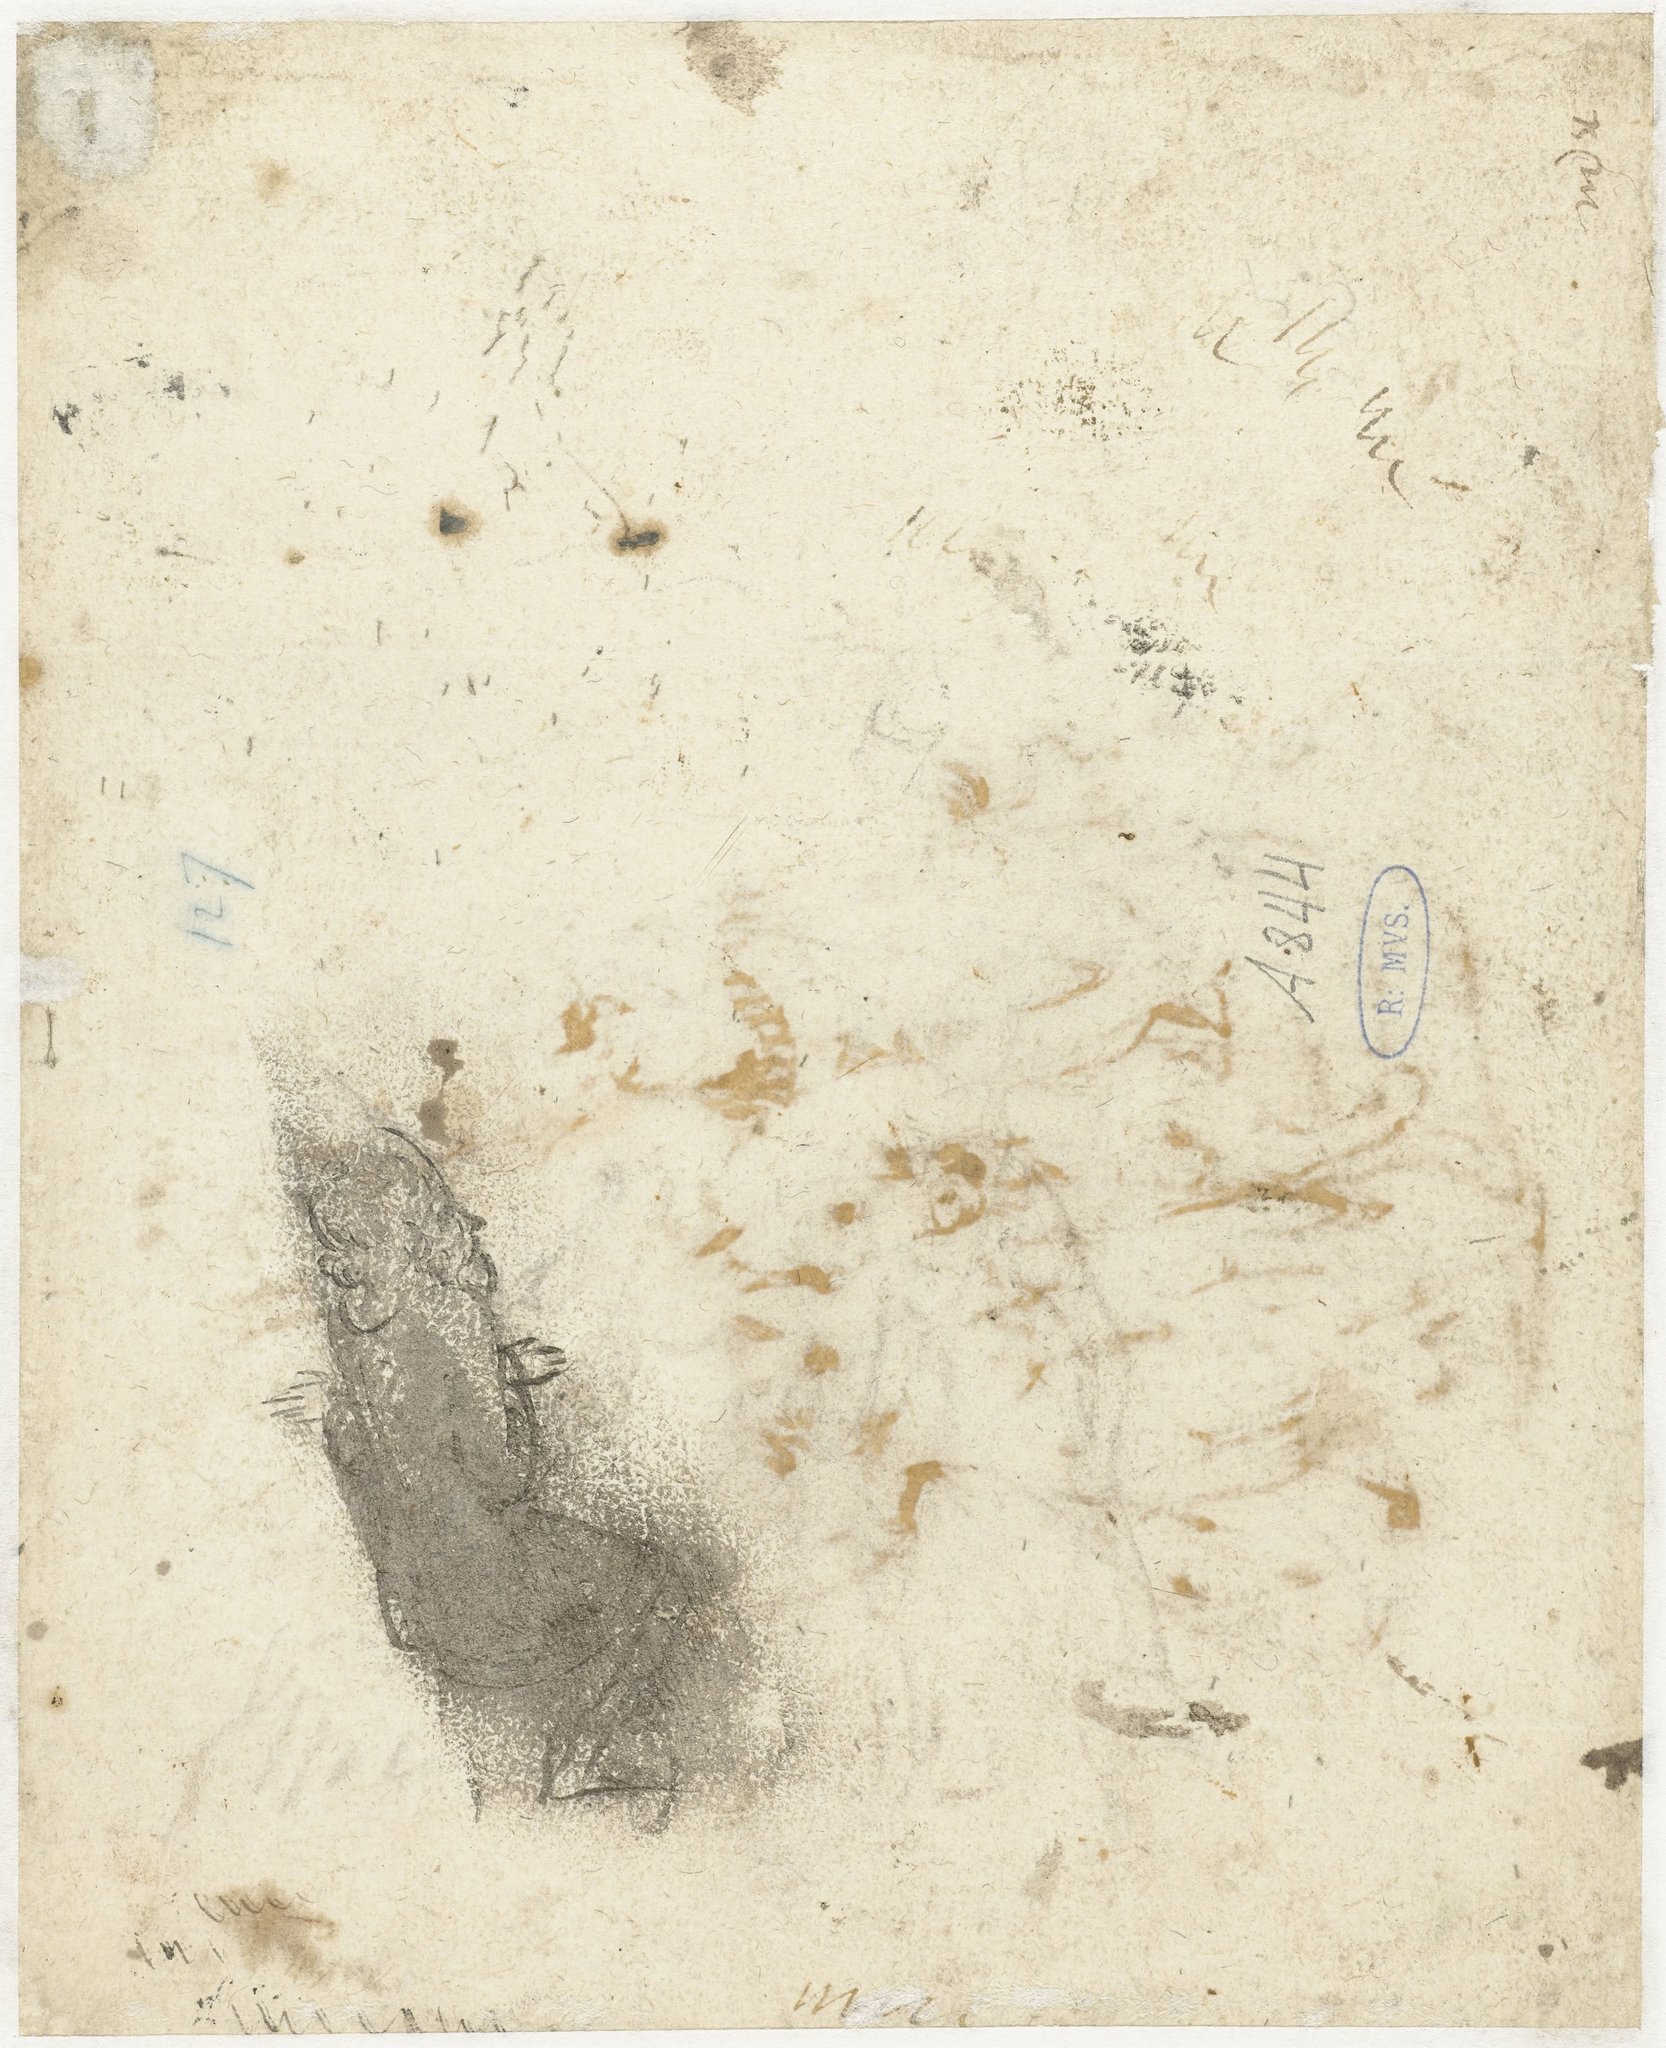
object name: drawing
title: Schets van een bebaarde man, van achteren gezien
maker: gerard ter borch (i)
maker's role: draughtsman, print maker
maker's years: 1584-1662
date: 1615-1655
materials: ink, paper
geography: zwolle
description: Figuur is gerelateerd aan de middenfiguur in Gerard's "Avondmaal te Emmaus", in Plakboek folio 131. Misschien een kopie van de middenfiguur uit folio 131 of een verloren gegane figuurstudie, gekopieerd door een van de kinderen van Gerard ter Borch.